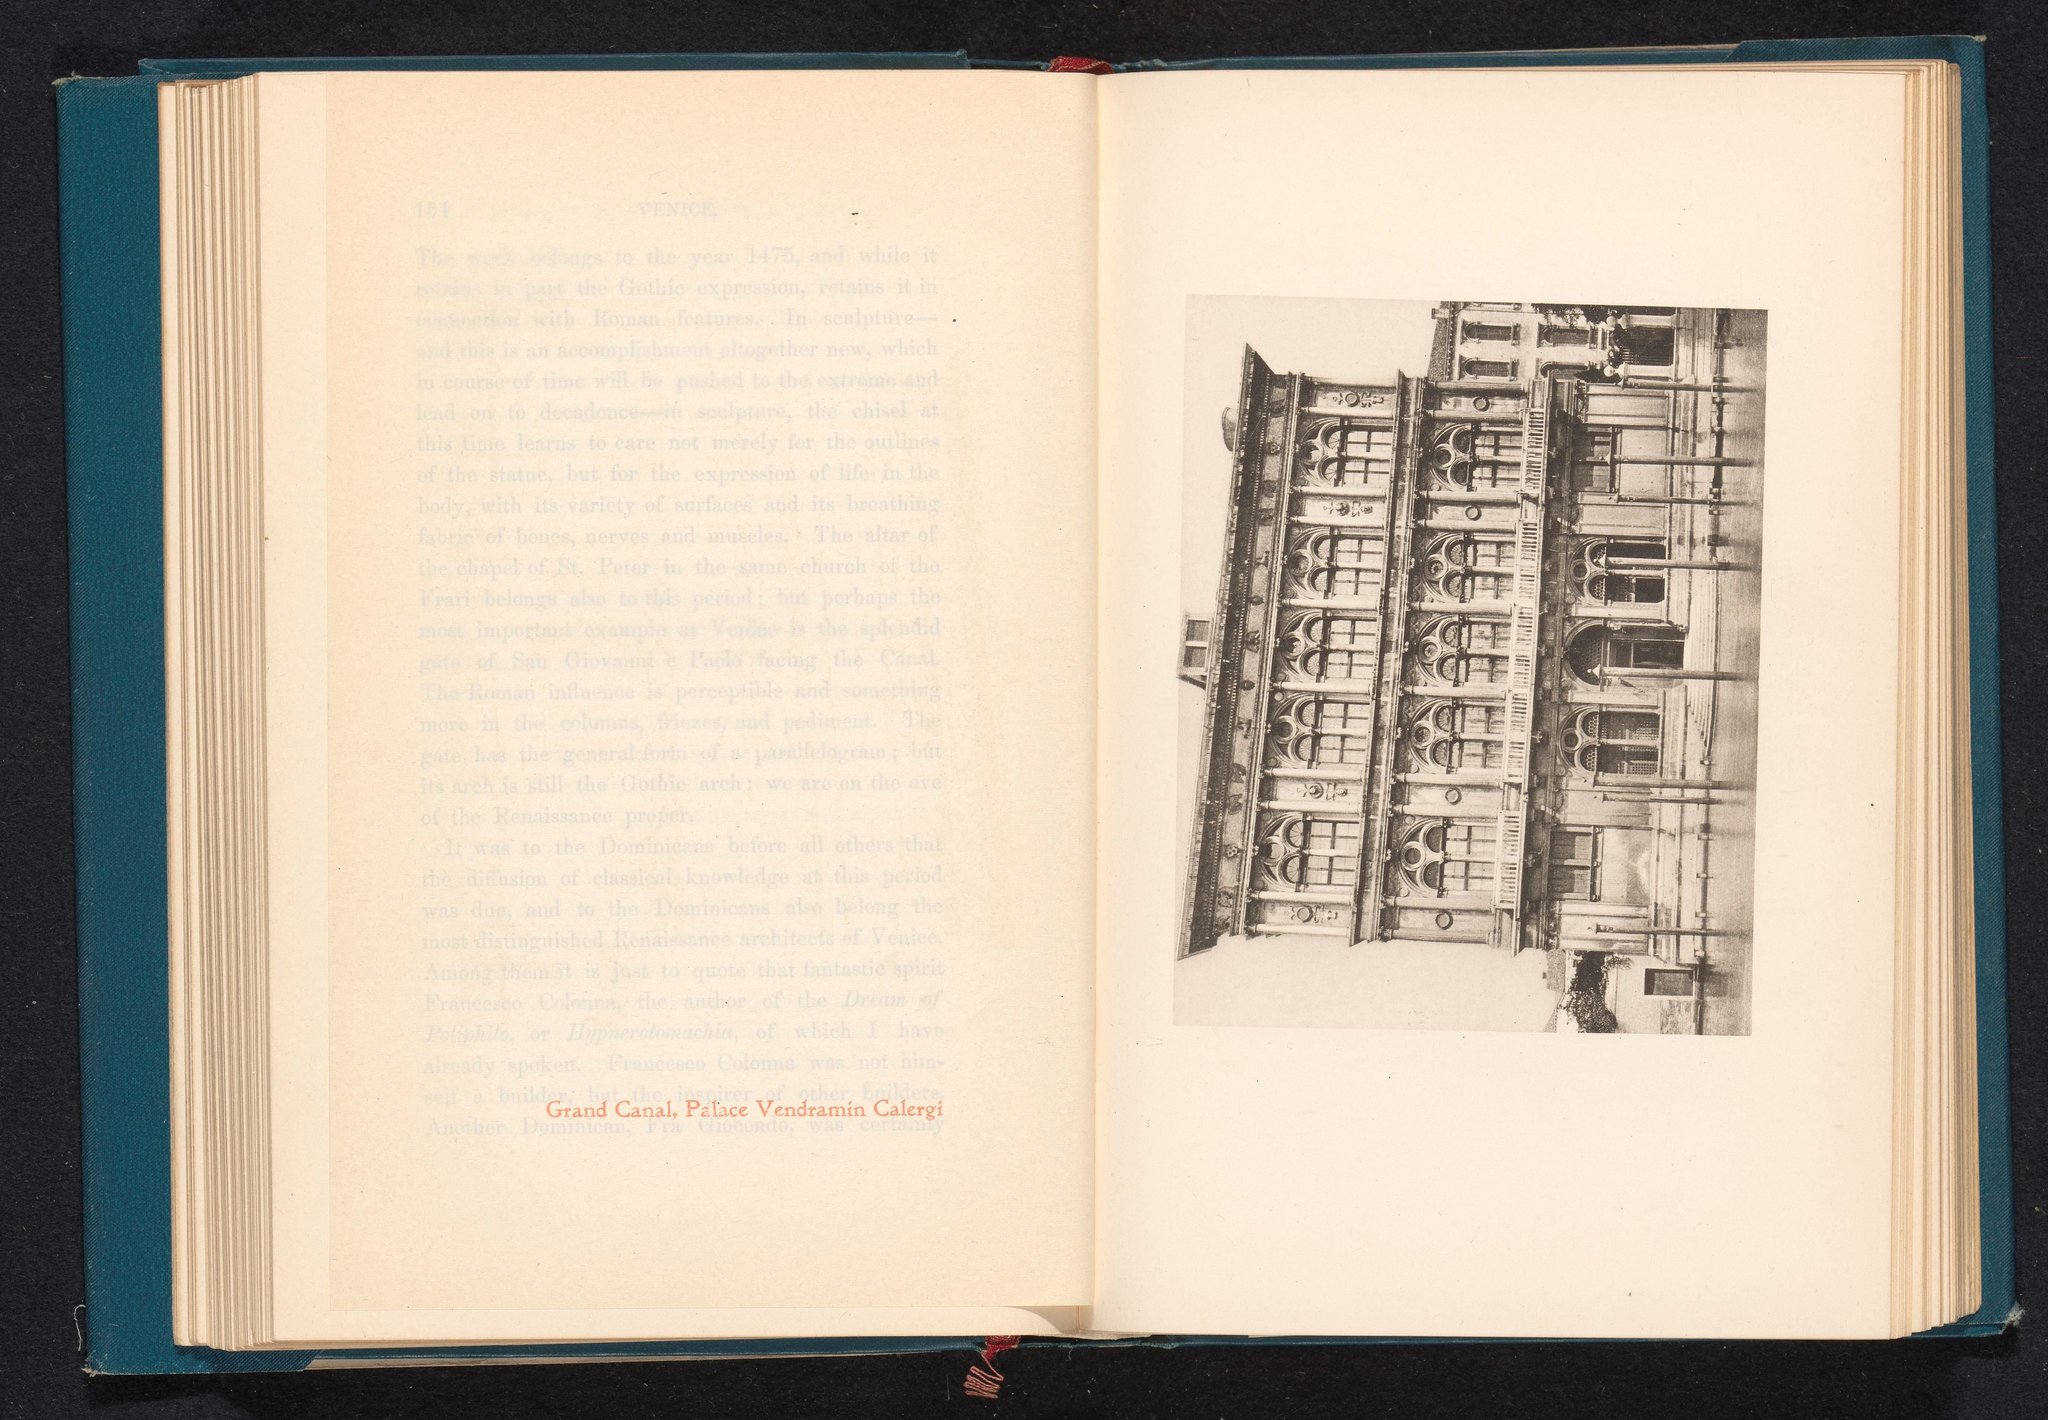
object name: photomechanical print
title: Exterieur van het Palazzo Vendramin-Calergi te Venetië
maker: Anonymous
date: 1882-1892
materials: paper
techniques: photoaquatint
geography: boston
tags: hôtel, i.e. small palace in city, façade (of house or building)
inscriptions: title: ‘Grand Canal, Palace Vendramin Calergi’